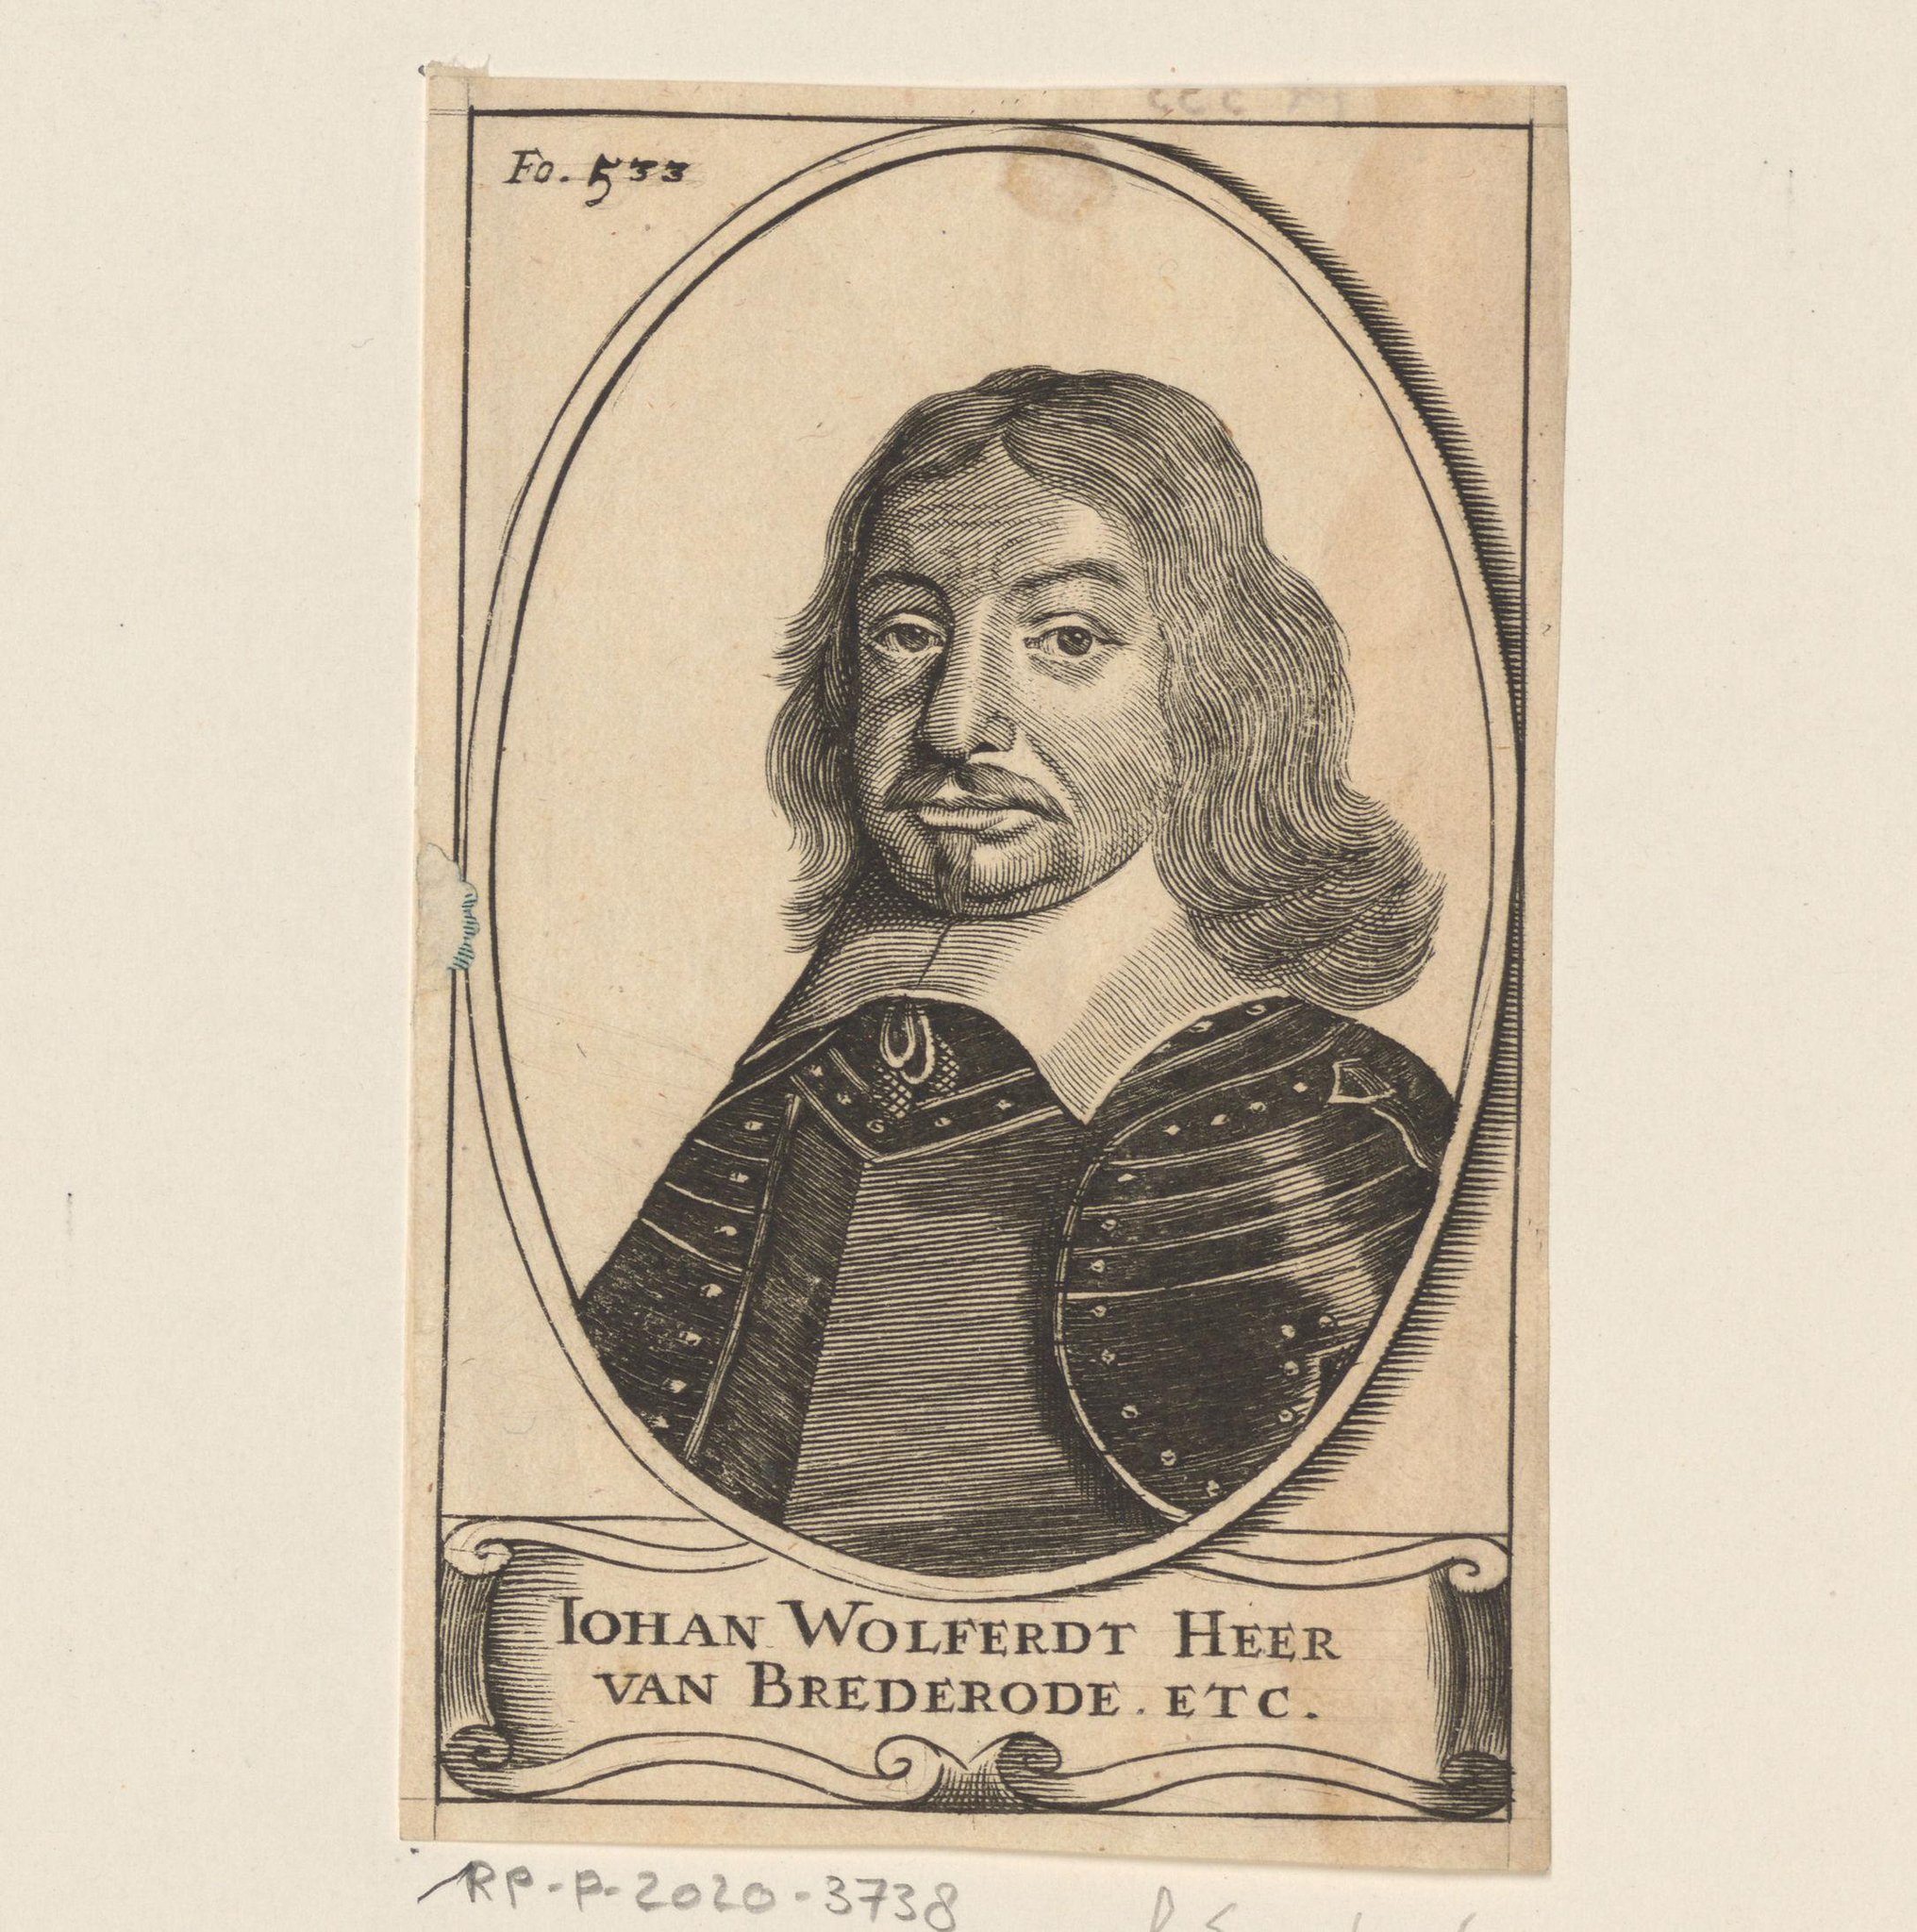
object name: book illustration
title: Portret van Joan Wolfert van Brederode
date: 1658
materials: paper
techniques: engraving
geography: leeuwarden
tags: armour, historical persons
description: Prent uit: Sande, Johan van den. De wakende leeuw, der Nederlanden historie (...). Leeuwarden: Gysbert Sybes, 1658.